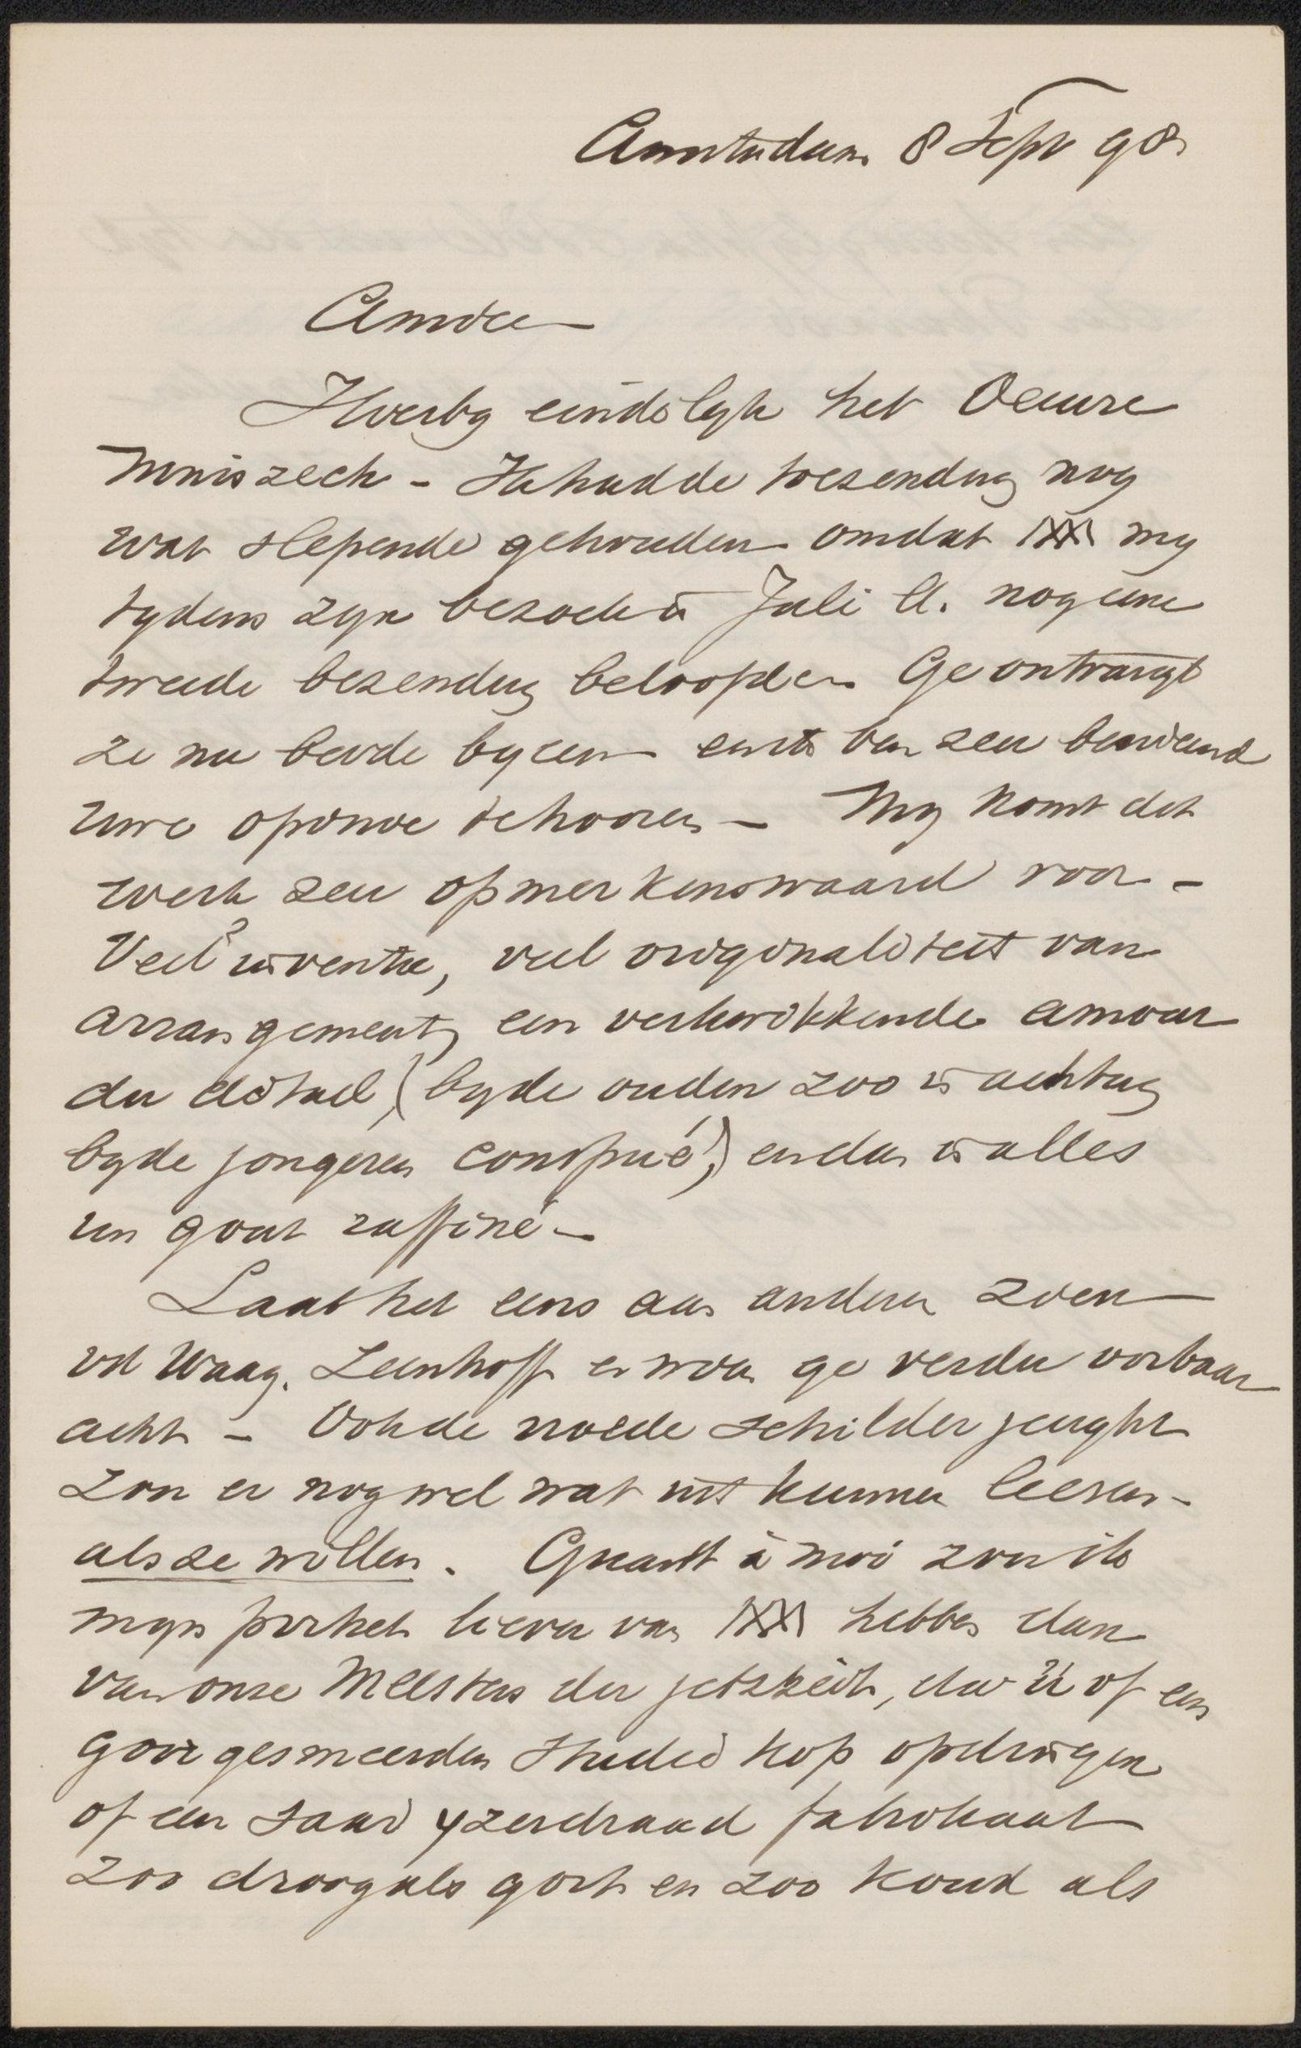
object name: letter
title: Brief aan August Allebé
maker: jan hendrik maschaupt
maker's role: painter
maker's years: 1826-1903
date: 1898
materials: ink, paper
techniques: pen, writing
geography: amsterdam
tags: painter, andrzej graaf mniszech, amsterdam, print maker, draughtsman, august allebé, nicolaas van der waay, ferdinand leenhoff